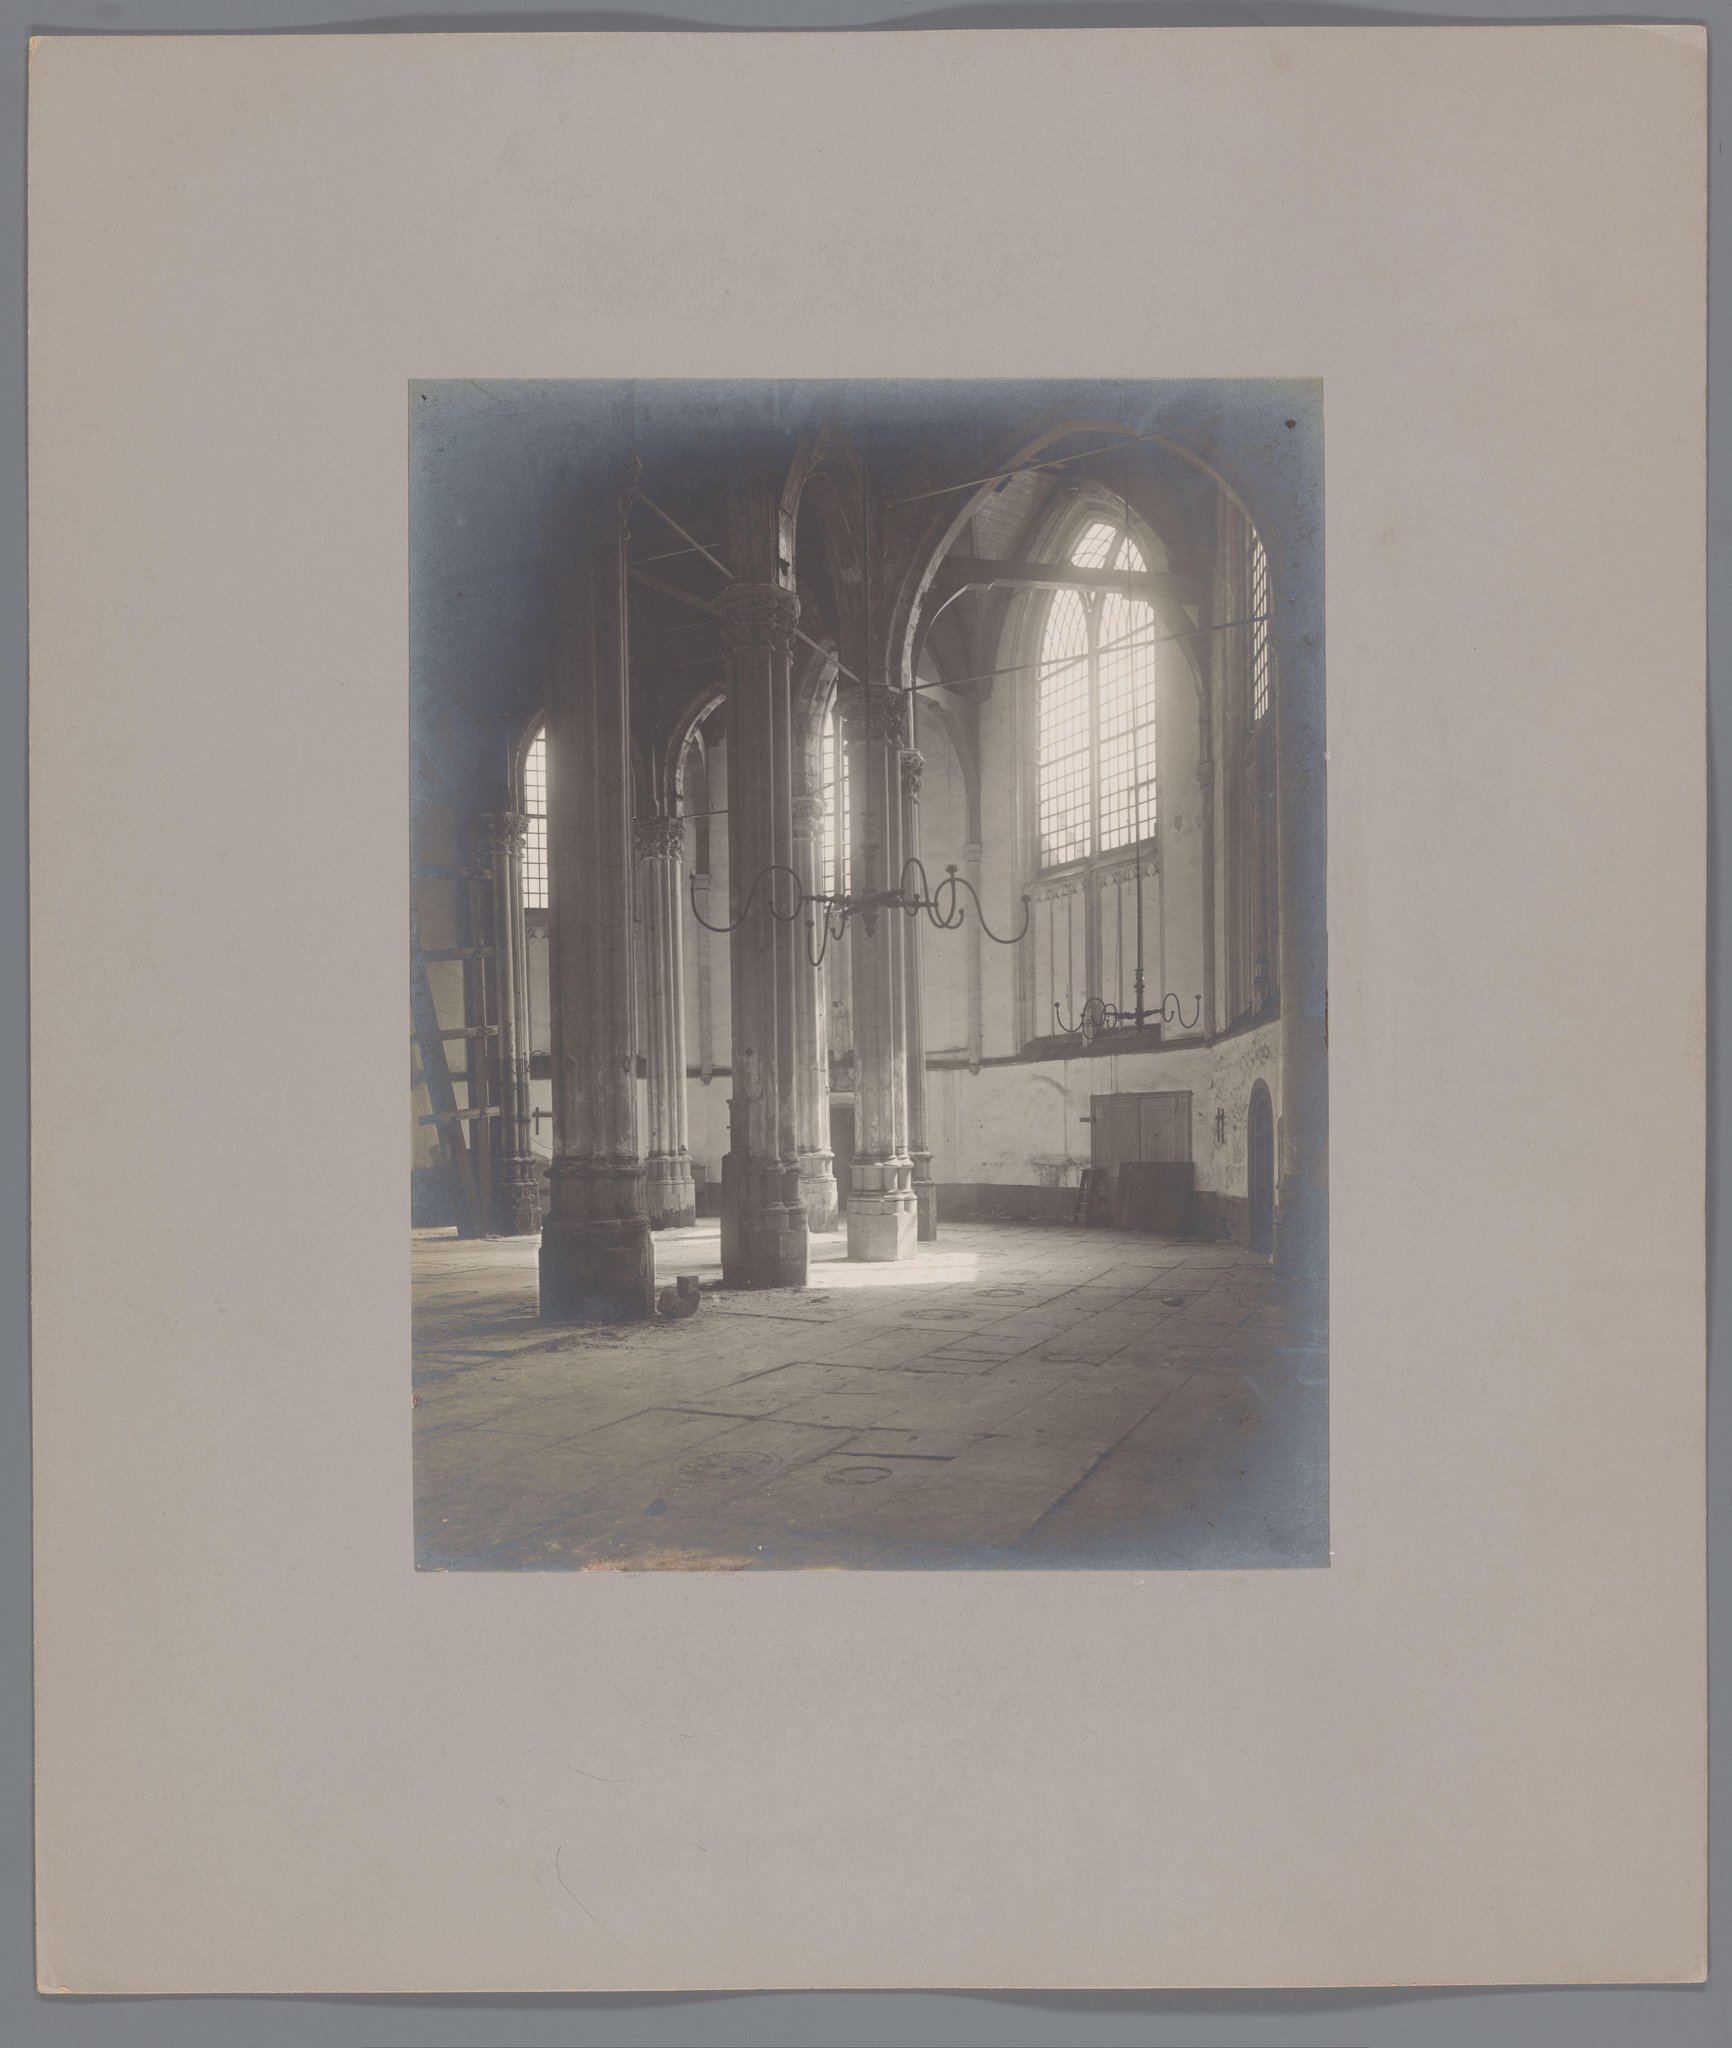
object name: photograph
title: Interieur van de Nieuwezijds Kapel te Amsterdam, tijdens de sloop in 1908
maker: albert adriaansz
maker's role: fotograaf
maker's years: 1877-1941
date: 1908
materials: cardboard, photographic support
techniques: gelatin silver print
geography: amsterdam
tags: interior of church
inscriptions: number: ‘'08.157’, inscription: ‘Adriaansz. Photographie/ Planciustr: No.63/ Amsterdam’, collector's mark: Lugt 2228